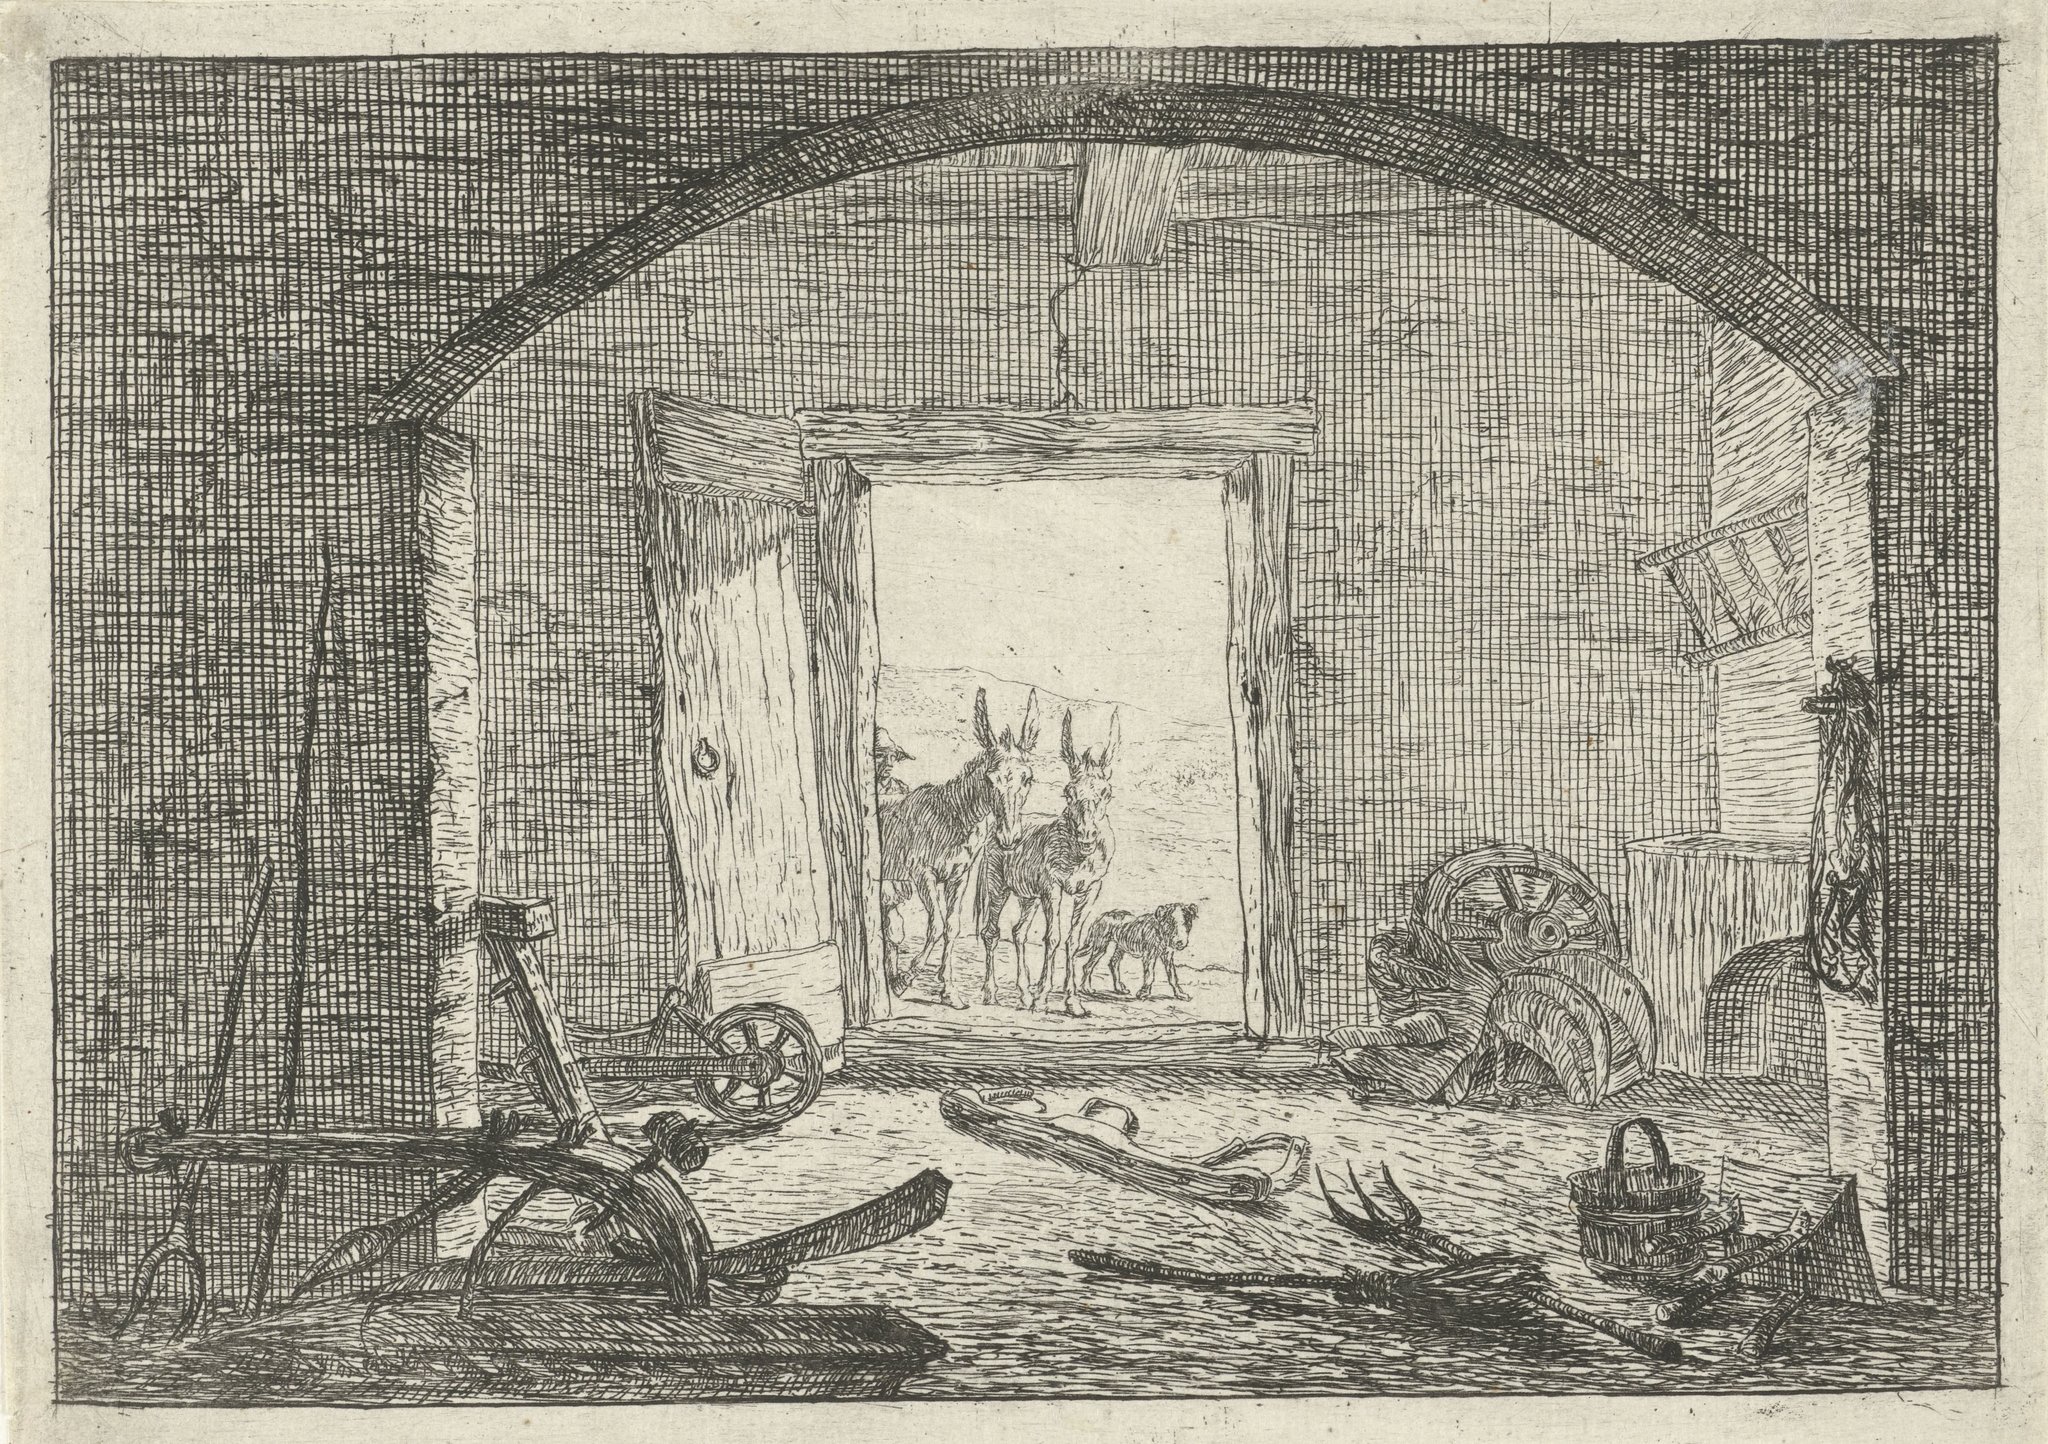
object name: print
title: Verschillende dieren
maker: pieter bodding van laer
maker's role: draughtsman, painter, print maker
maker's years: 1599-1642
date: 1636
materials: paper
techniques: etching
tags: barn, ass, donkey, agricultural implements, dog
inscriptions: collector's mark: Lugt 240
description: Interieur van een schuur met verschillende landbouwwerktuigen. Voor de open deur staan twee ezels en een hond. De prent maakt deel uit van een achtdelige serie met voorstellingen van verschillende dieren.